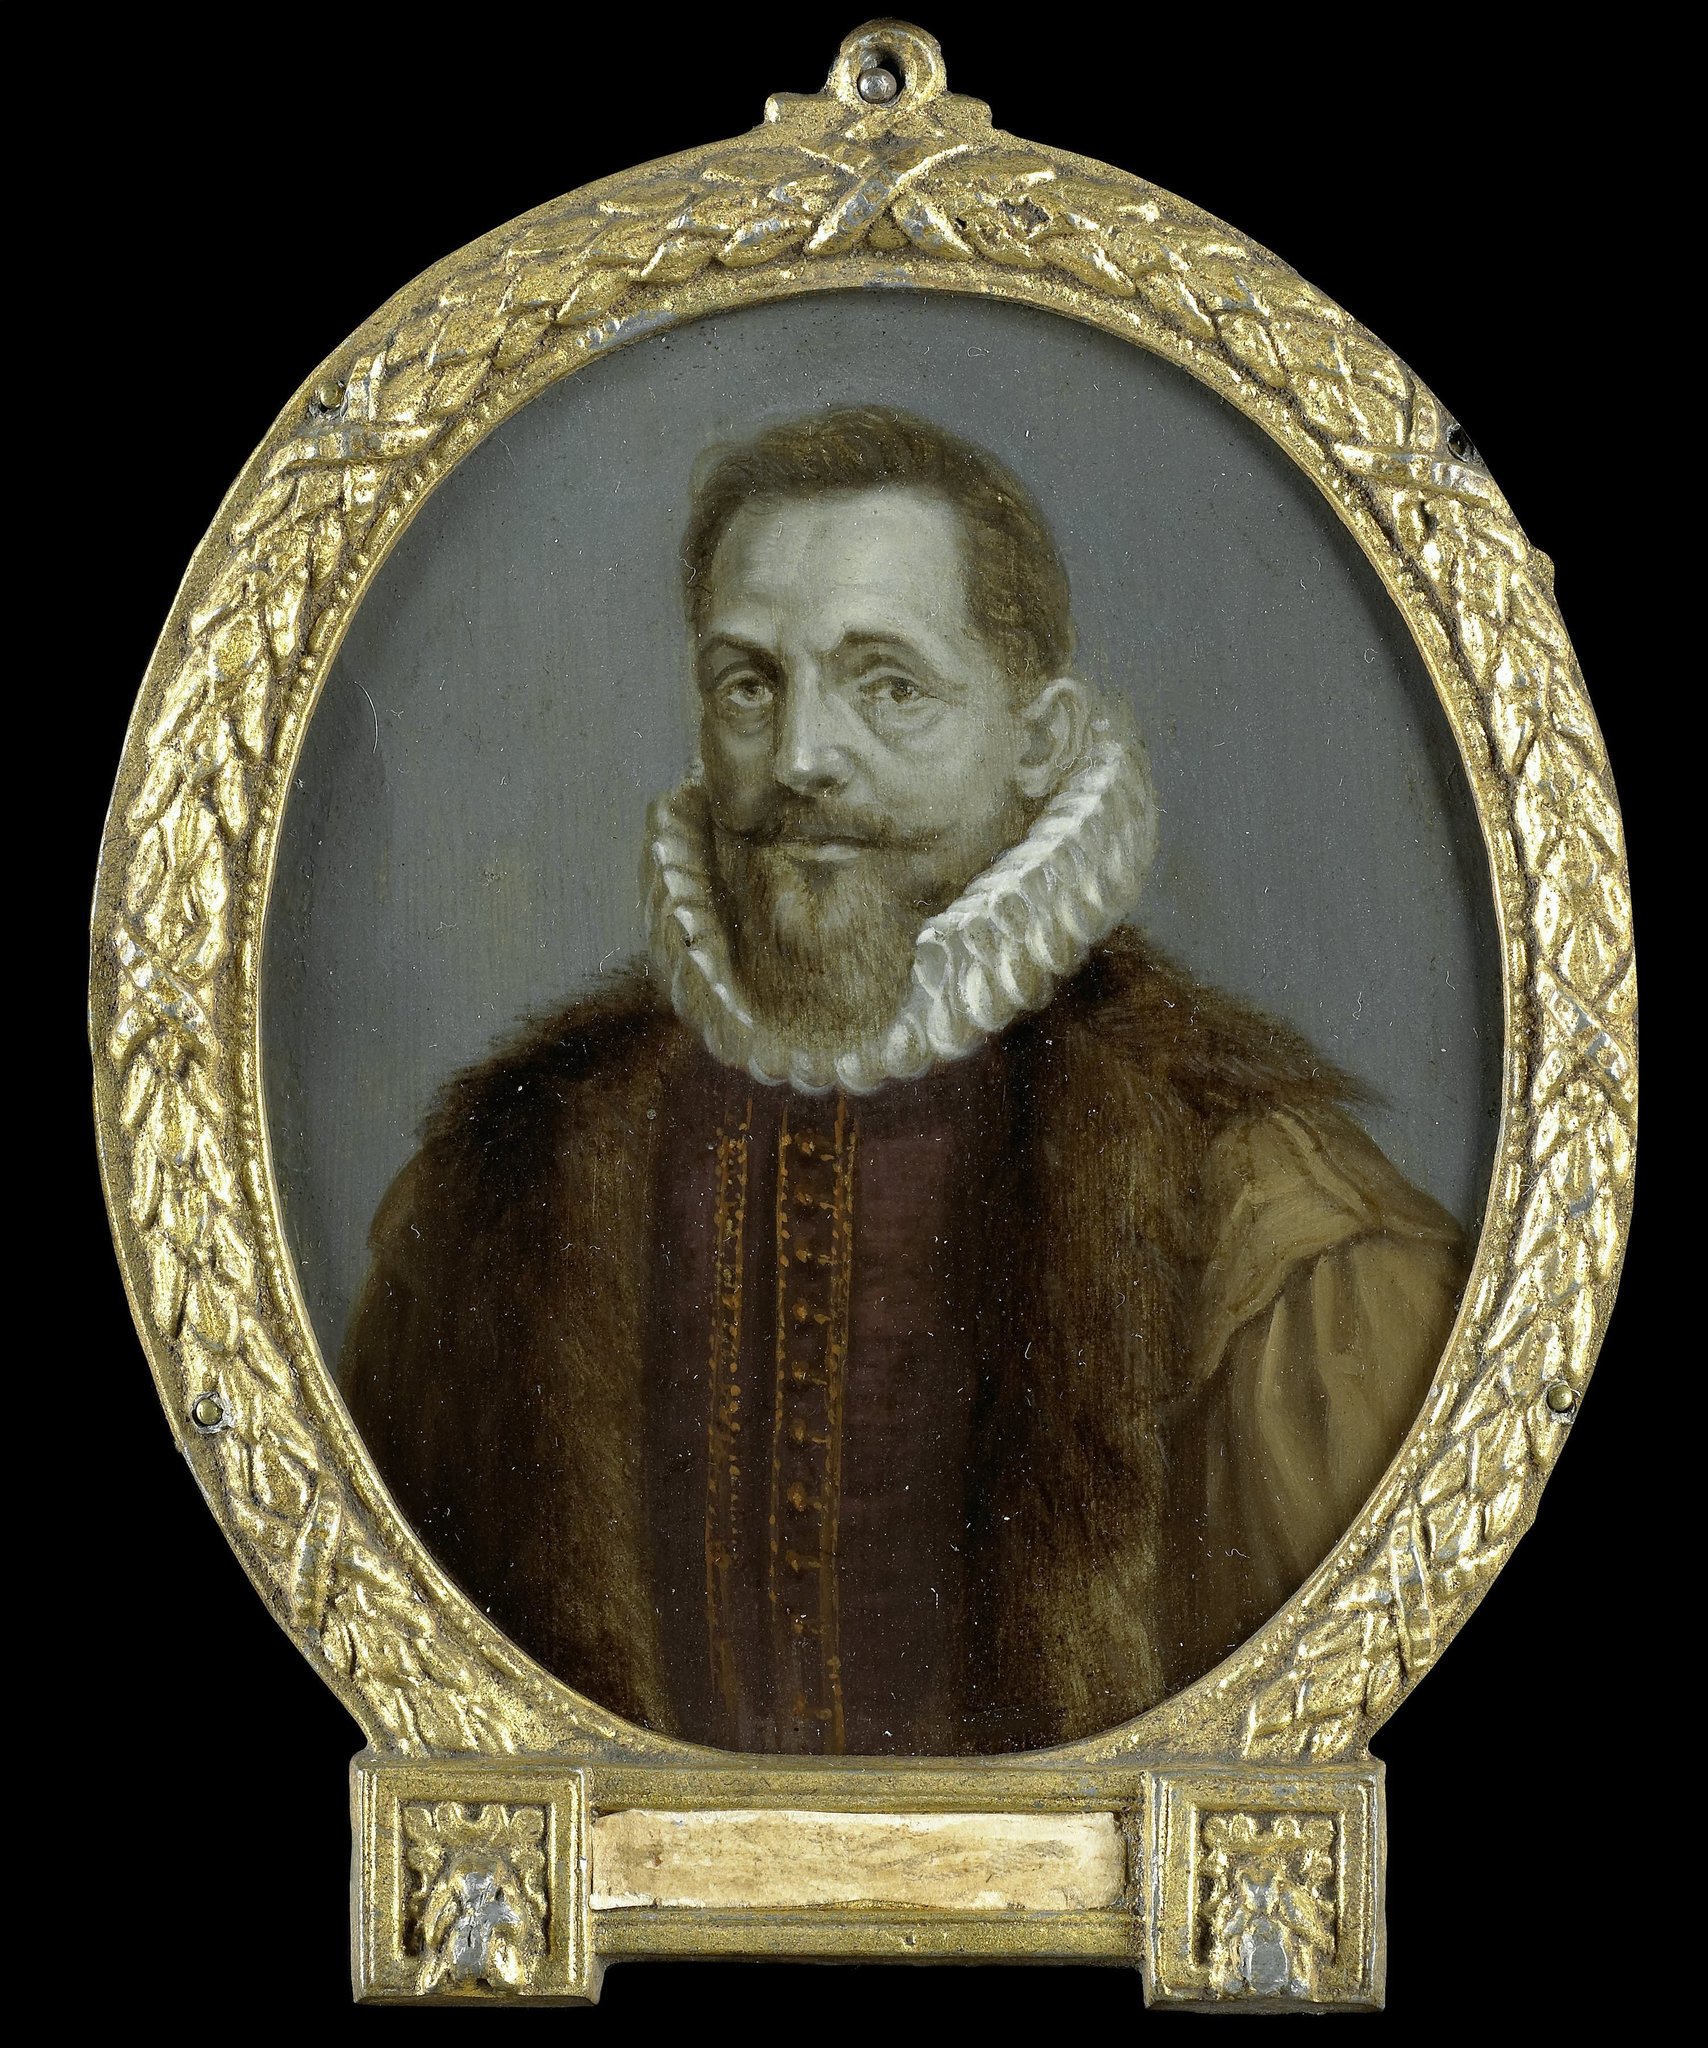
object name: grisaille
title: Portrait of Petrus Bertius, Professor at Leiden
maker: arnoud van halen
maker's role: draughtsman, painter, print maker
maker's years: 1673-1732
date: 1700-1732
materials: oil, metal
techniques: grisaille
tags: paris, portrait of a writer, writer, poet, author, leiden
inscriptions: inscription: ‘P. Bertinus Nat. 1565 / Ob.t 1629’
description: Portret van Petrus Bertius (1565-1629). Hoogleraar te Leiden. Buste in ovaal, naar links. Onderdeel van een verzameling portretten van Nederlandse dichters.